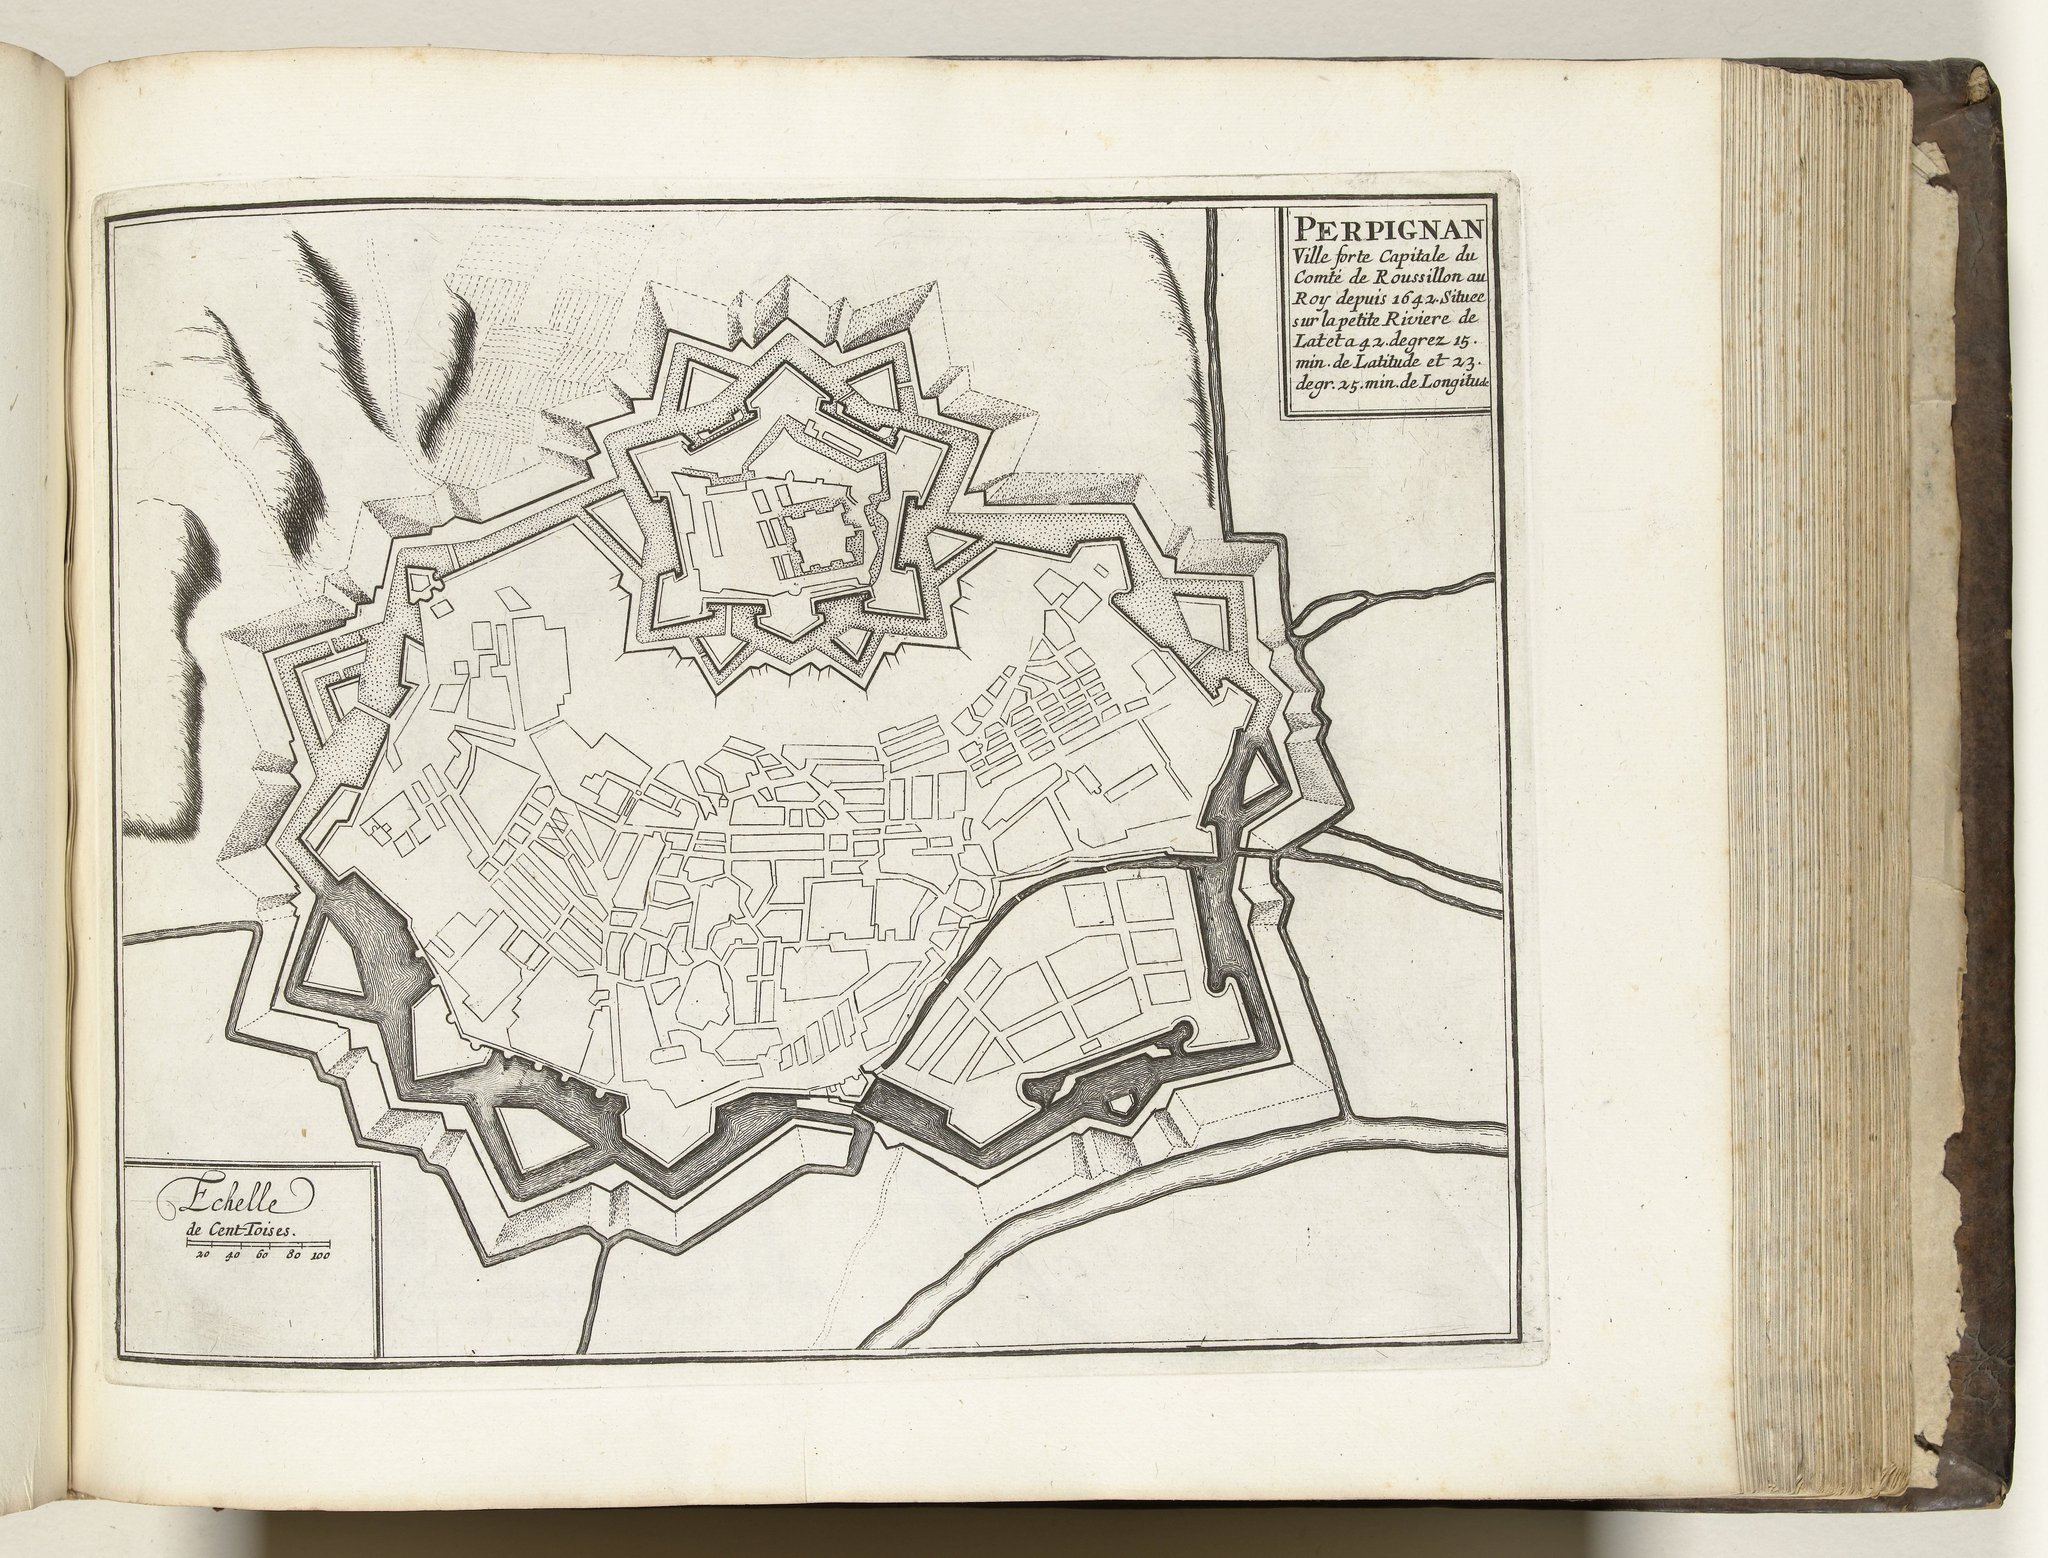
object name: print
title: Perpignan Ville forte Capitale du Comté de Roussillon (...)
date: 1693-1696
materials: paper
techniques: etching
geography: paris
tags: fortress, maps of cities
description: Plattegrond van de versterkingen om de Franse stad Perpignan. Onderdeel van het zesde deel (1696) van het prentwerk waarin gebundeld zijn de acht delen van Les forces de l'Europe uitgegeven tussen 1693-1697. Het prentwerk bestaat uit 175 platen met plannen (afkomstig van Sébastien Le Prestre, Seigneur de Vauban) van vermaarde sterke steden en vestingen in de Negenjarige Oorlog. Titel en opschriften in het Frans.